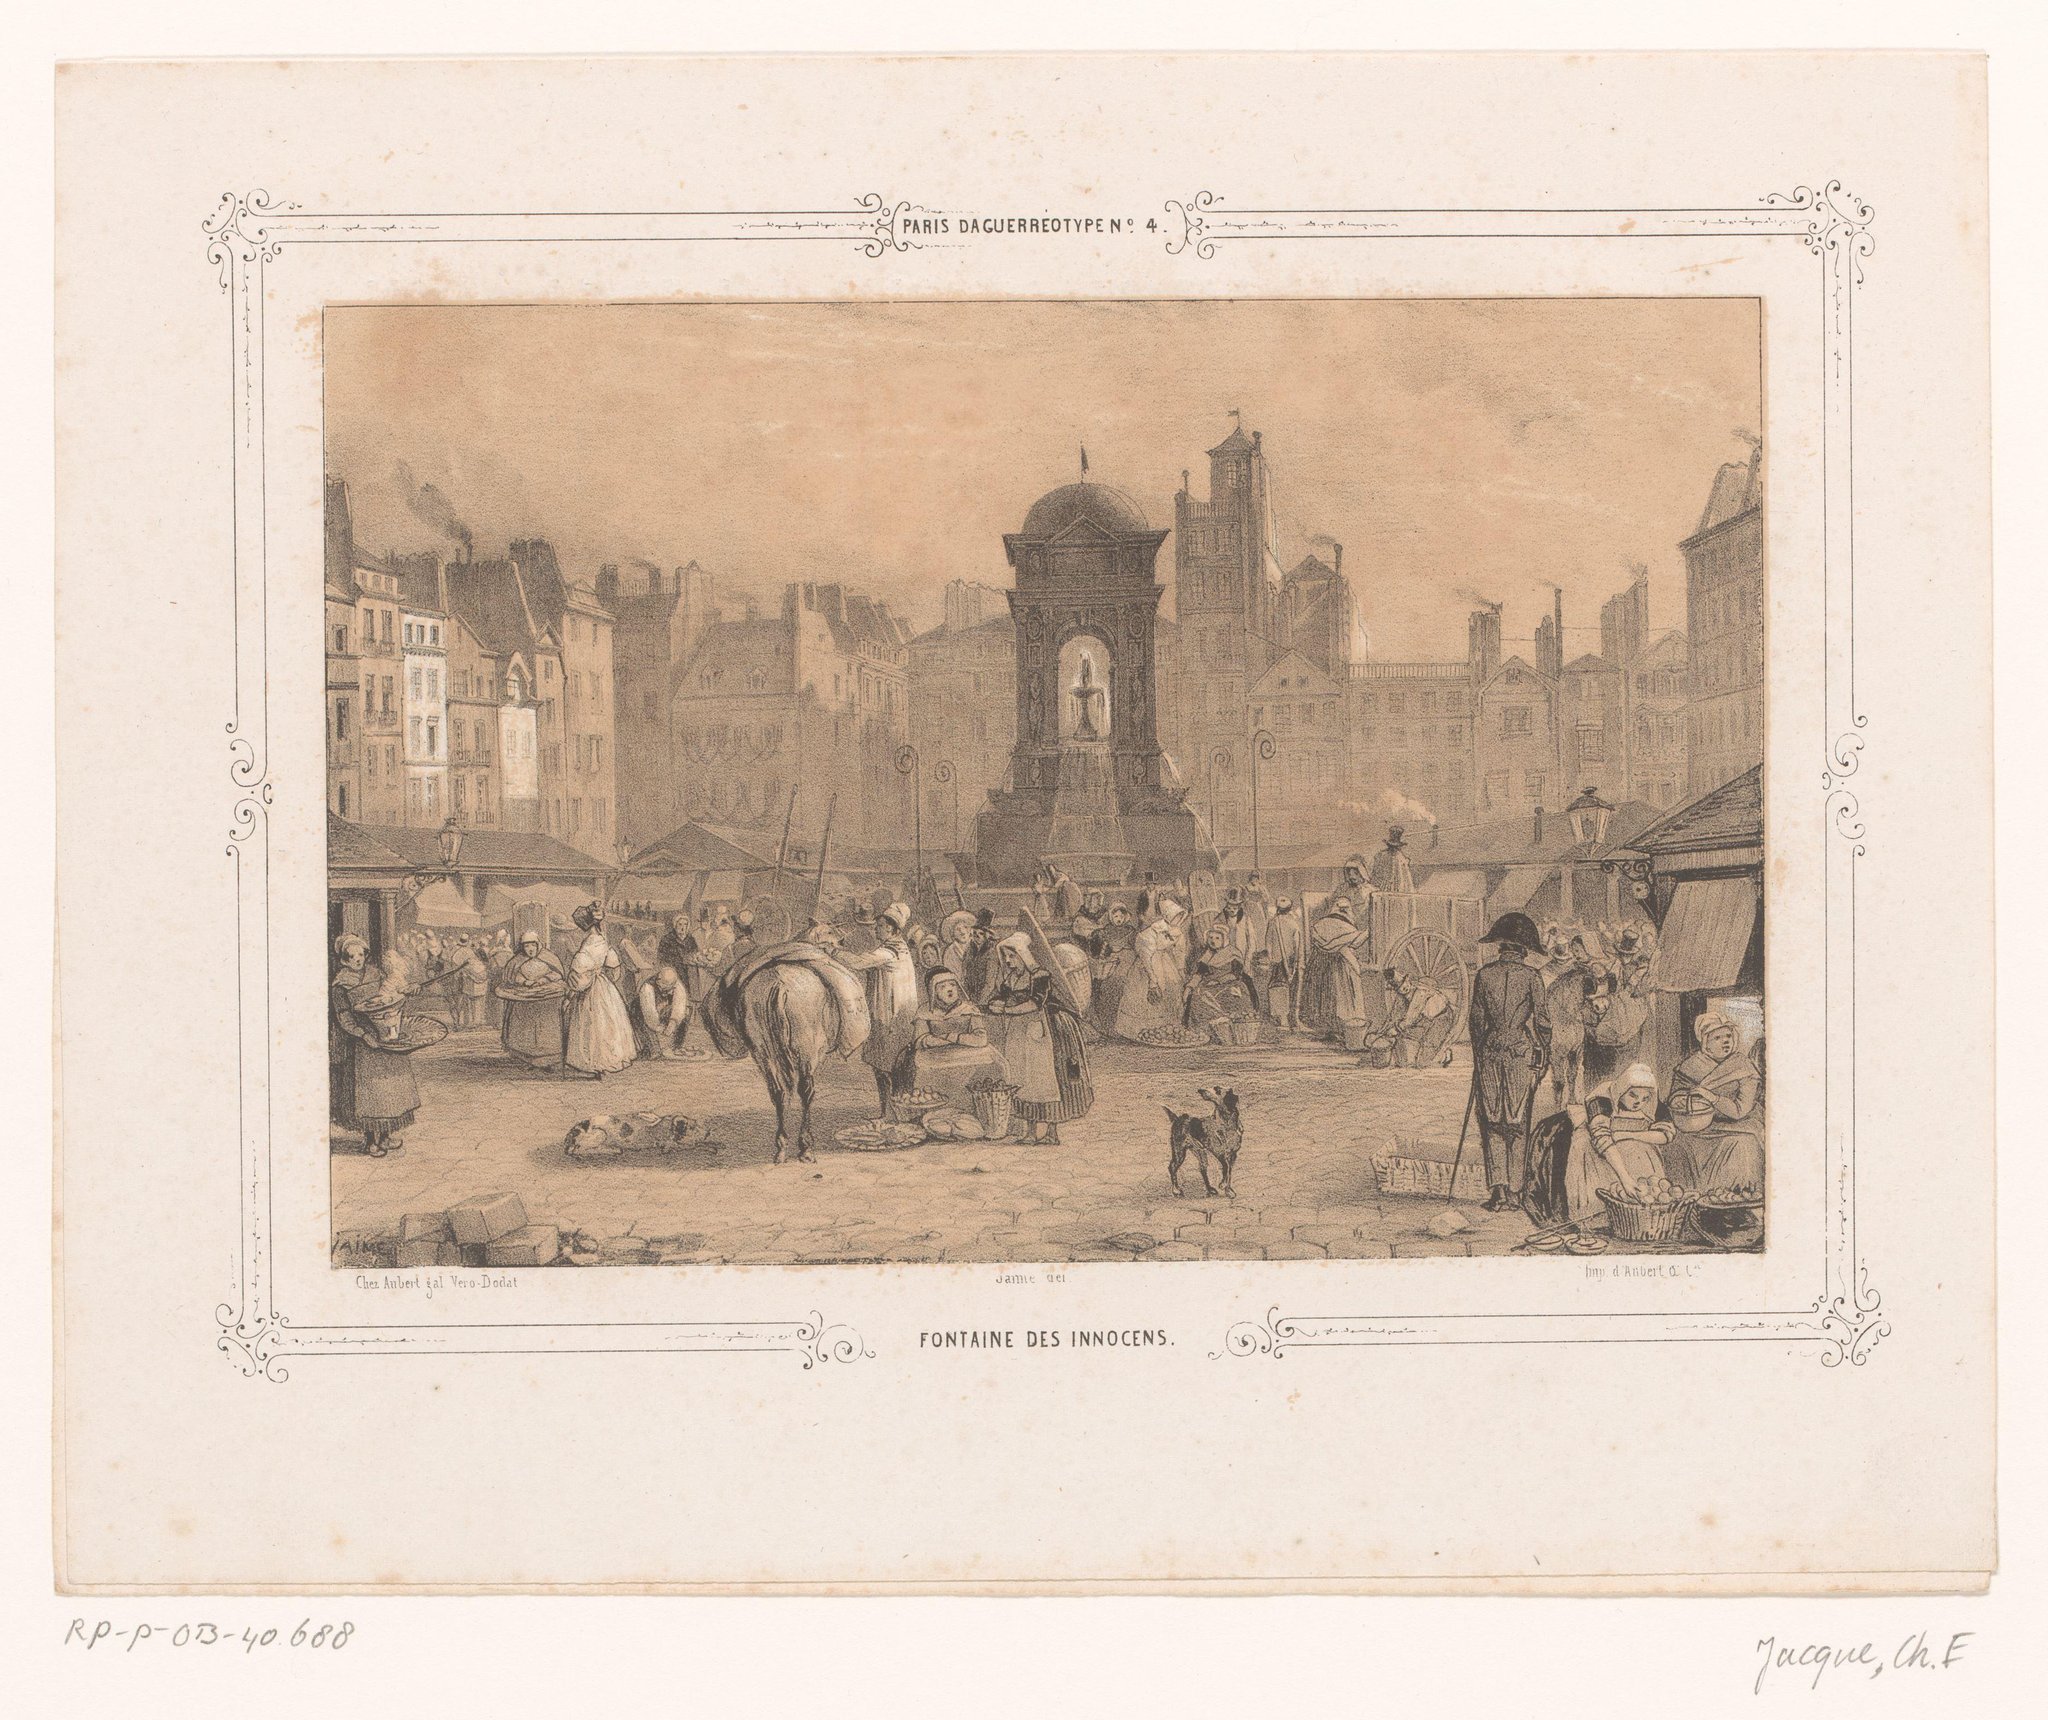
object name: print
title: Fontaine des innocents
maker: ernest jaime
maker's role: print maker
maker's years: 1802-1884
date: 1840-1842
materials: paper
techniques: letterpress printing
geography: amsterdam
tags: market, square, place, circus, etc. (+ city(-scape) with figures, staffage), ornamental fountain (+ city(-scape) with figures, staffage)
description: Prent uit: Philipon, Charles ed. Parys en deszelfs omstreken, voorgesteld door de daguerréotype, onder toezigt van M. Ch. Philipon. Bewerkt naar het Fransch met de oorspronkelyke platen. Amsterdam: Elix & Co., 1840-1842. Deze uitgave is in delen uitgegeven en kon uiteindelijk tot een boek worden ingebonden. Dit is de Nederlandse uitgave van: Philipon, Charles ed. Paris et ses environs reproduits par le daguerréotype, sous la direction de M. Ch. Philipon (…). Parijs: Aubert & Cie, 1840. Gevouwen blad met lithografie en drie tekstpagina's (p. 14-16).